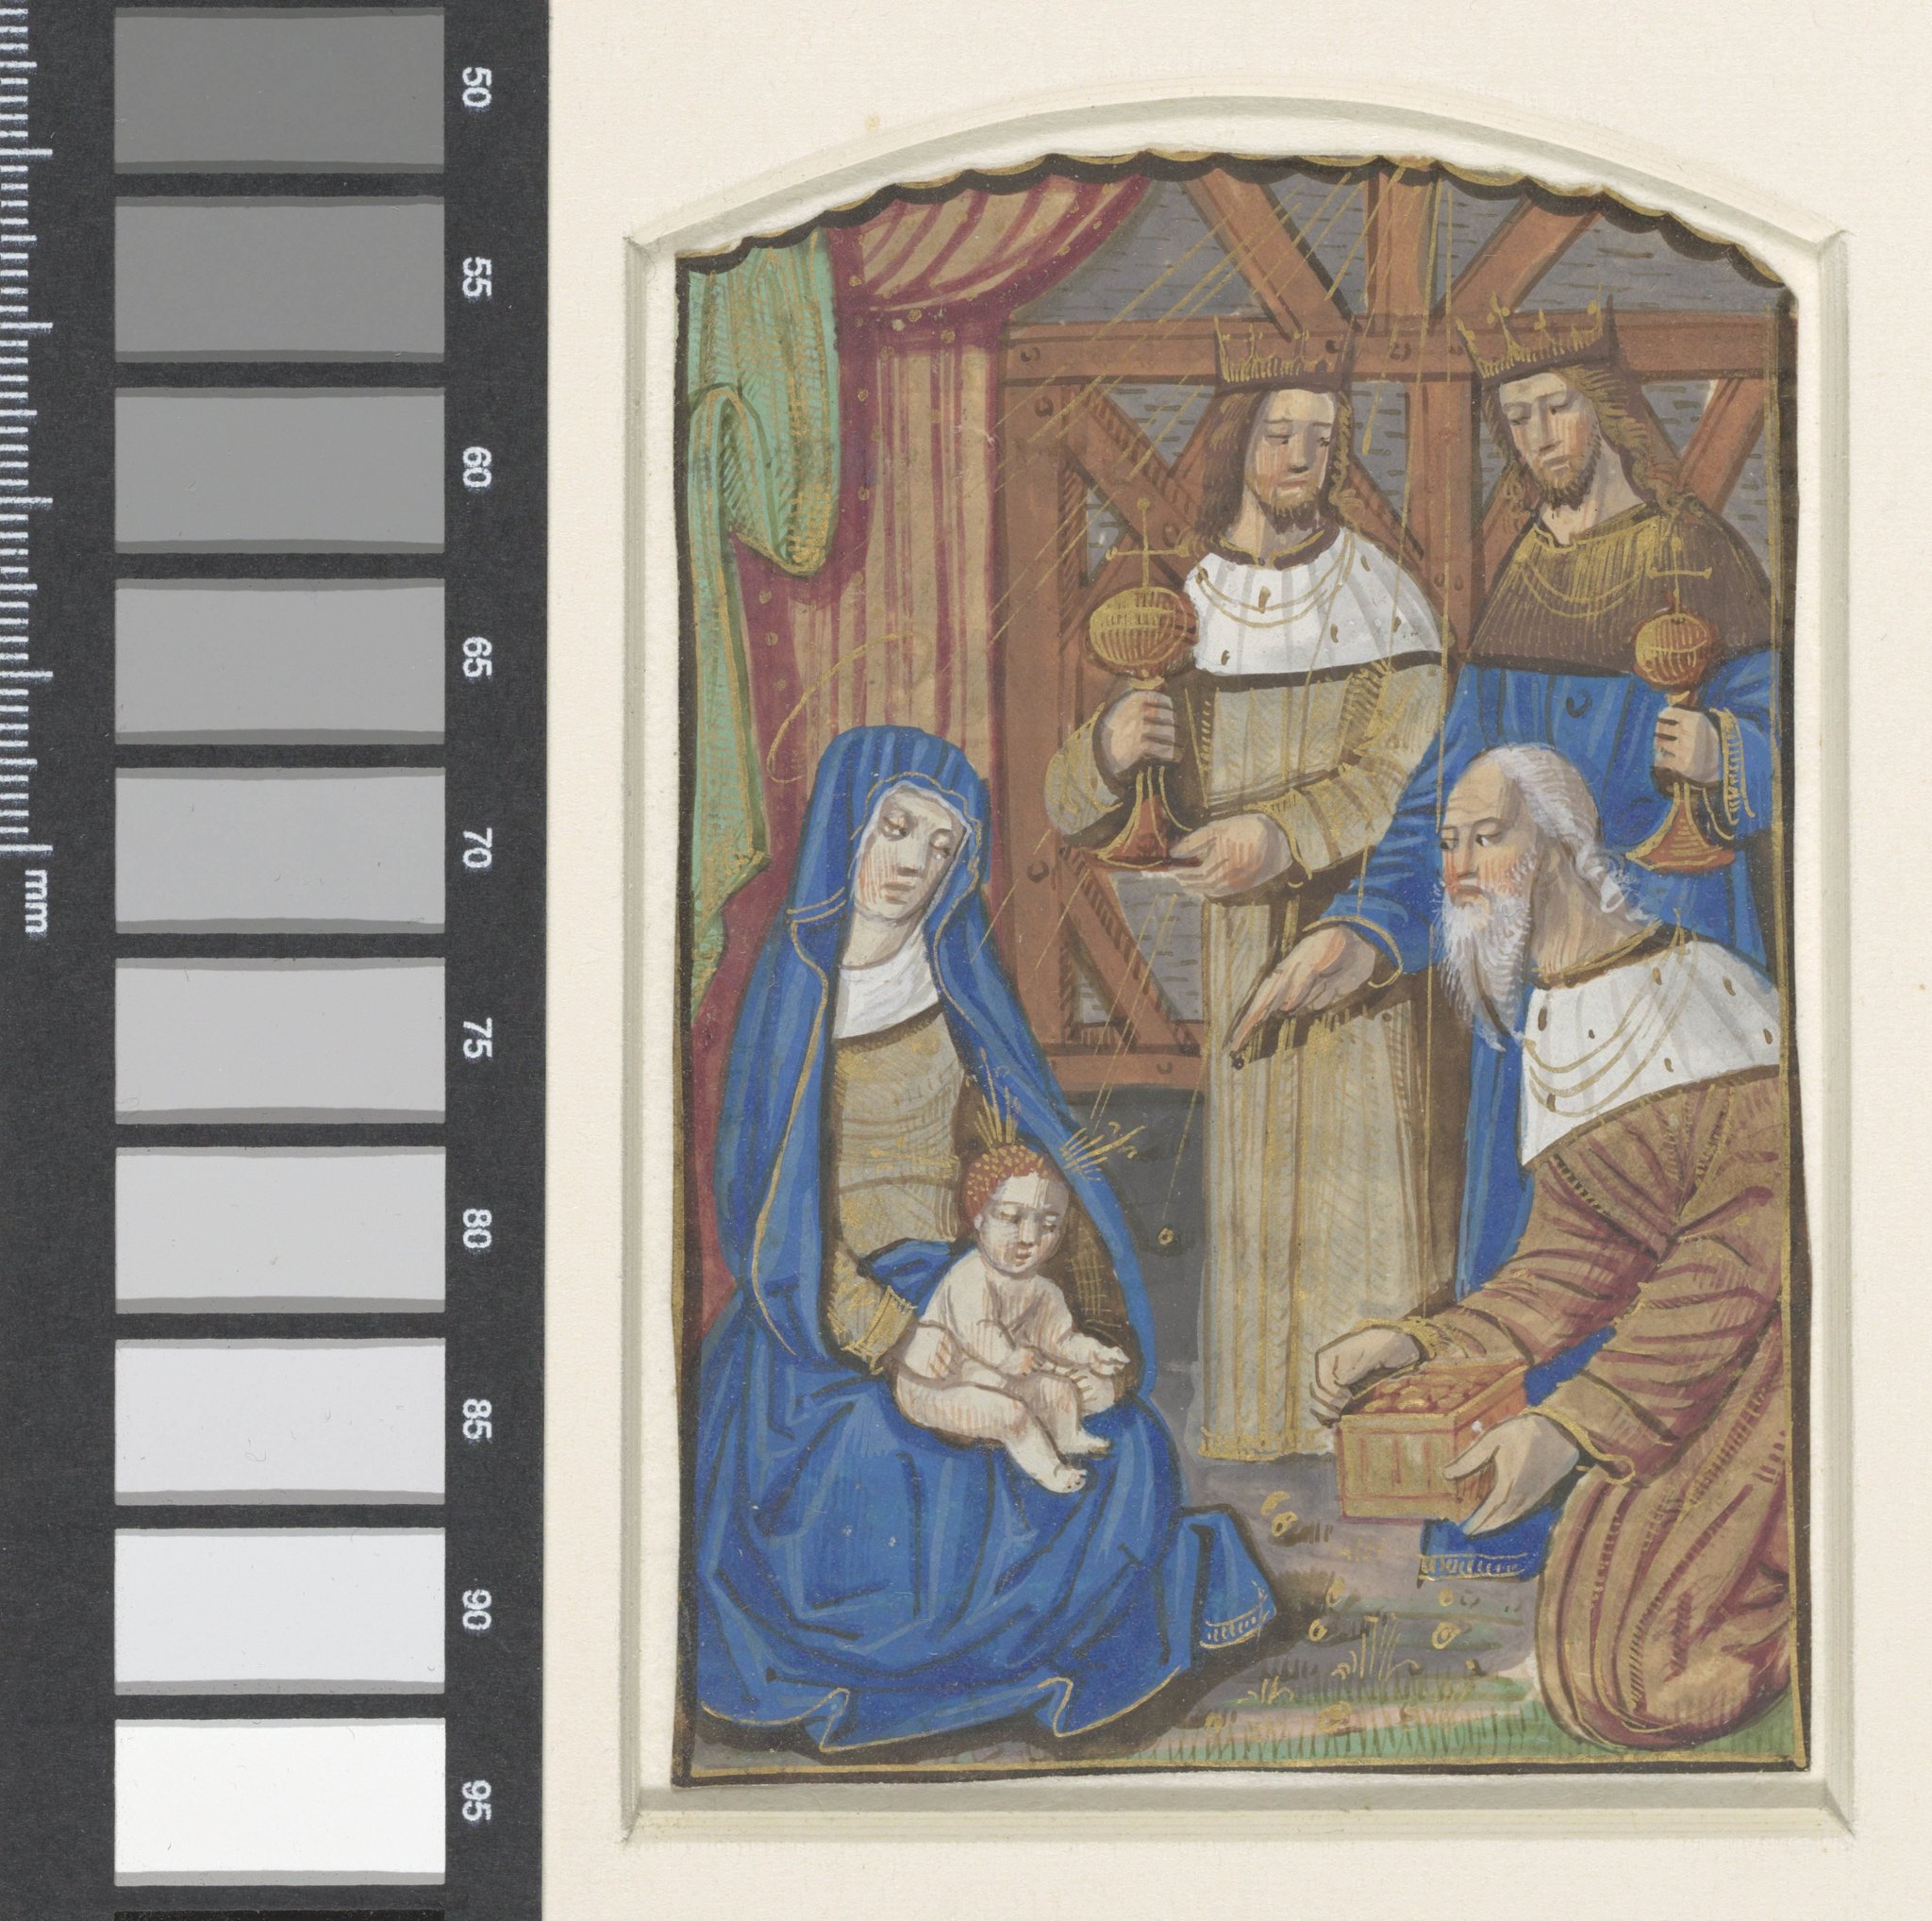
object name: drawing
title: Miniatuur uit een getijdenboek: aanbidding der koningen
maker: Anonymous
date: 1475-1500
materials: paint, gold leaf, parchment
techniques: brush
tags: adoration of the kings: the wise men present their gifts to the christ-child (gold, frankincense and myrrh)